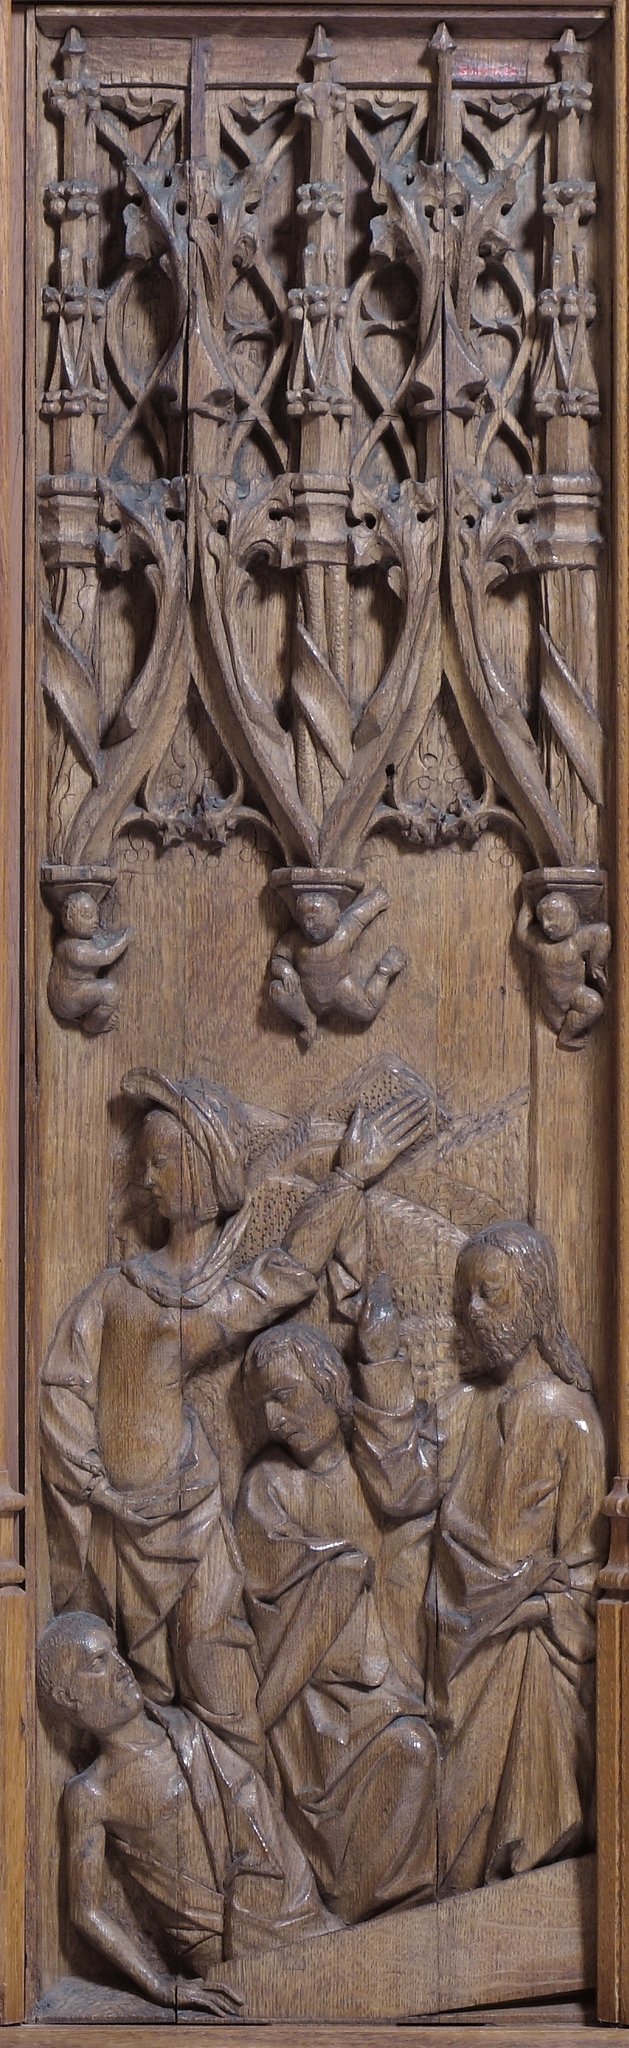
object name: panel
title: Panel with the Razing of Lazarus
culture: french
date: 1501-1533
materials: wood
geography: france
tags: men